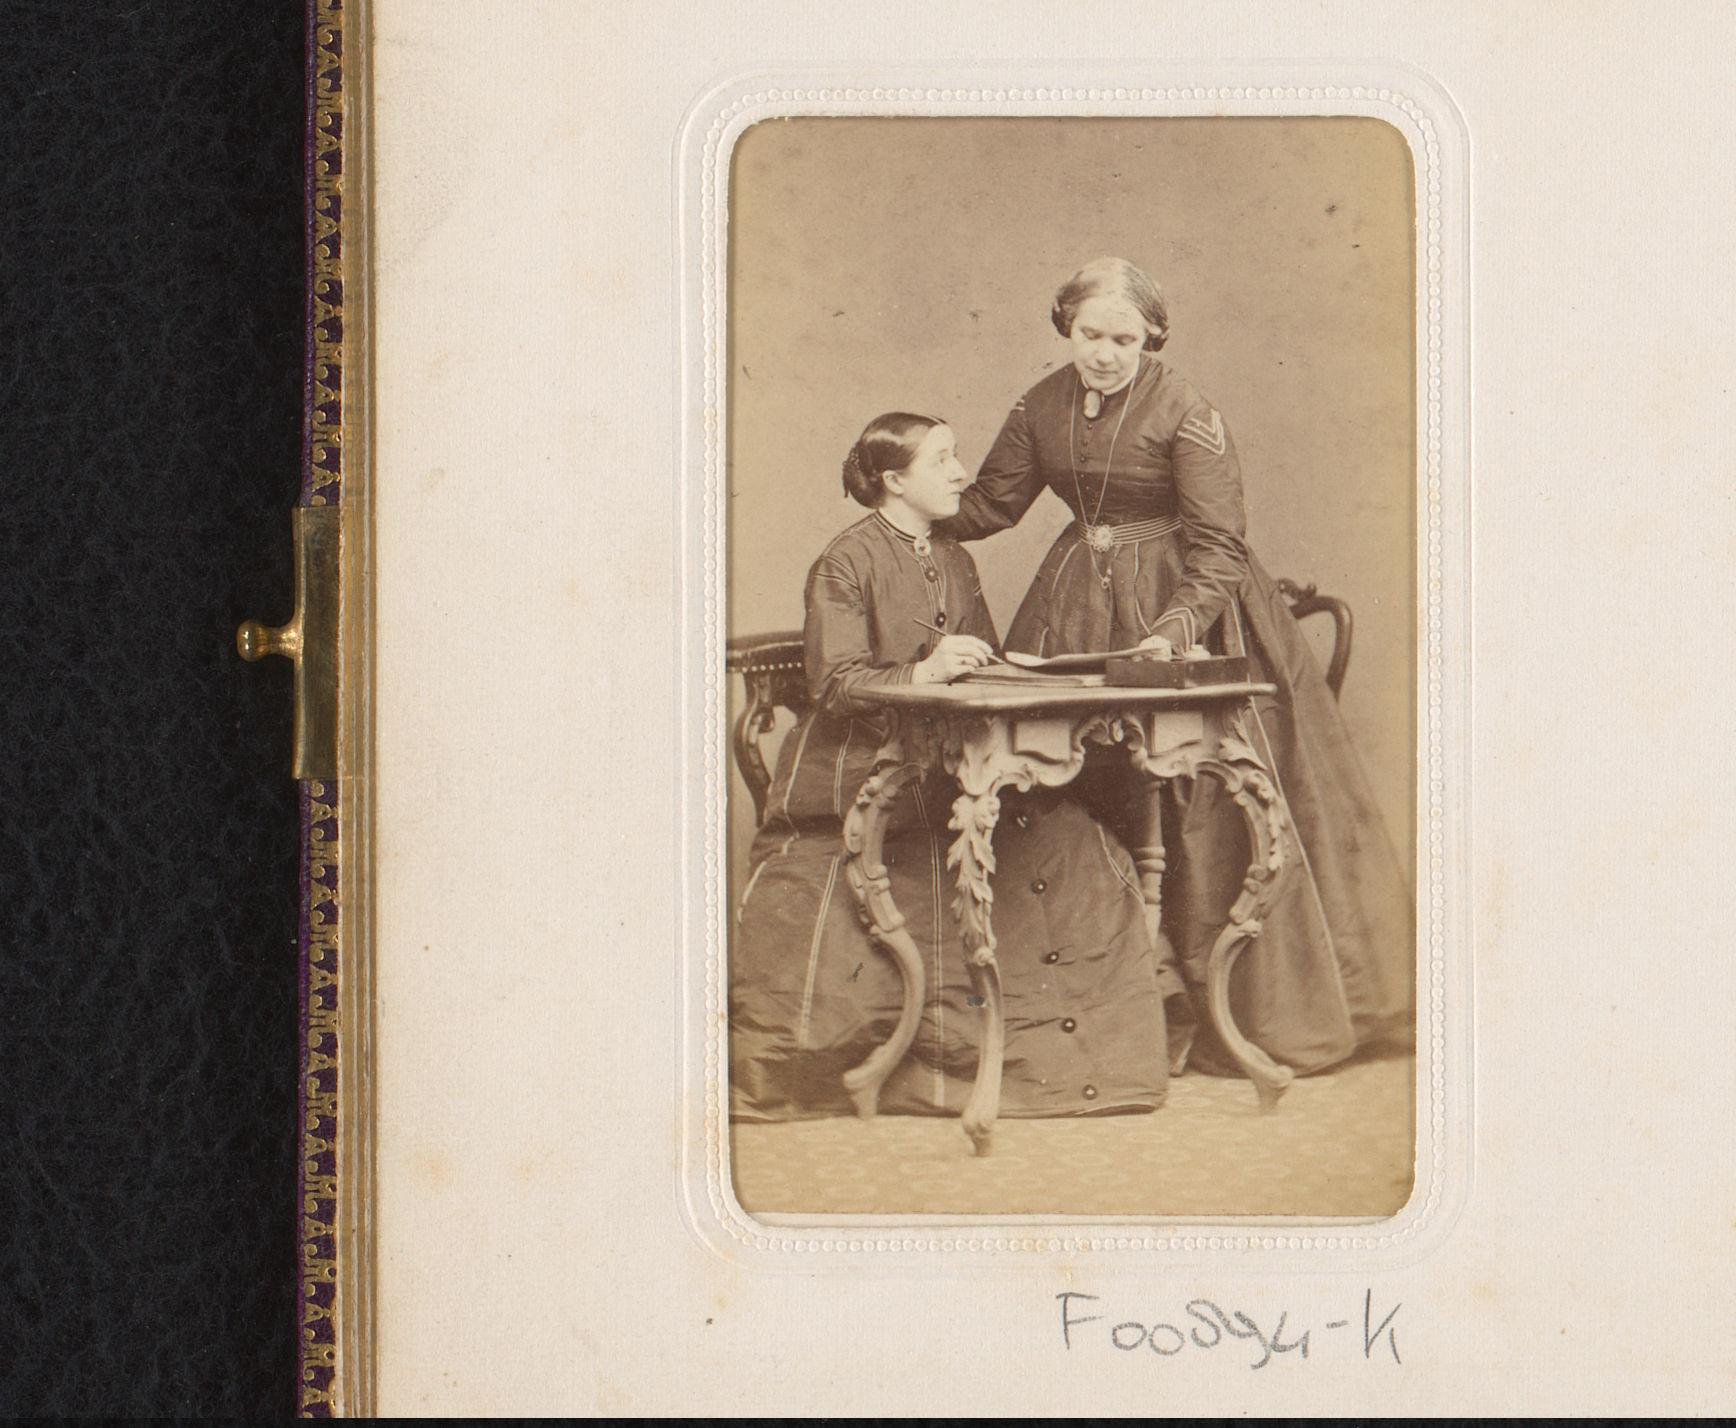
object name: carte de visite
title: Portret van twee vrouwen aan tafel met schrijfgerei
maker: charles binger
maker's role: print maker, printer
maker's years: 1830-1916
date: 1862-1869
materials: cardboard, photographic support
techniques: albumen print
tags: adult woman, writing tools, historical persons, table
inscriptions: inscription: ‘Photographische Inrigting/ CH. Binger & Co./ Zijlstraat No. 759/ te/ Haarlem’